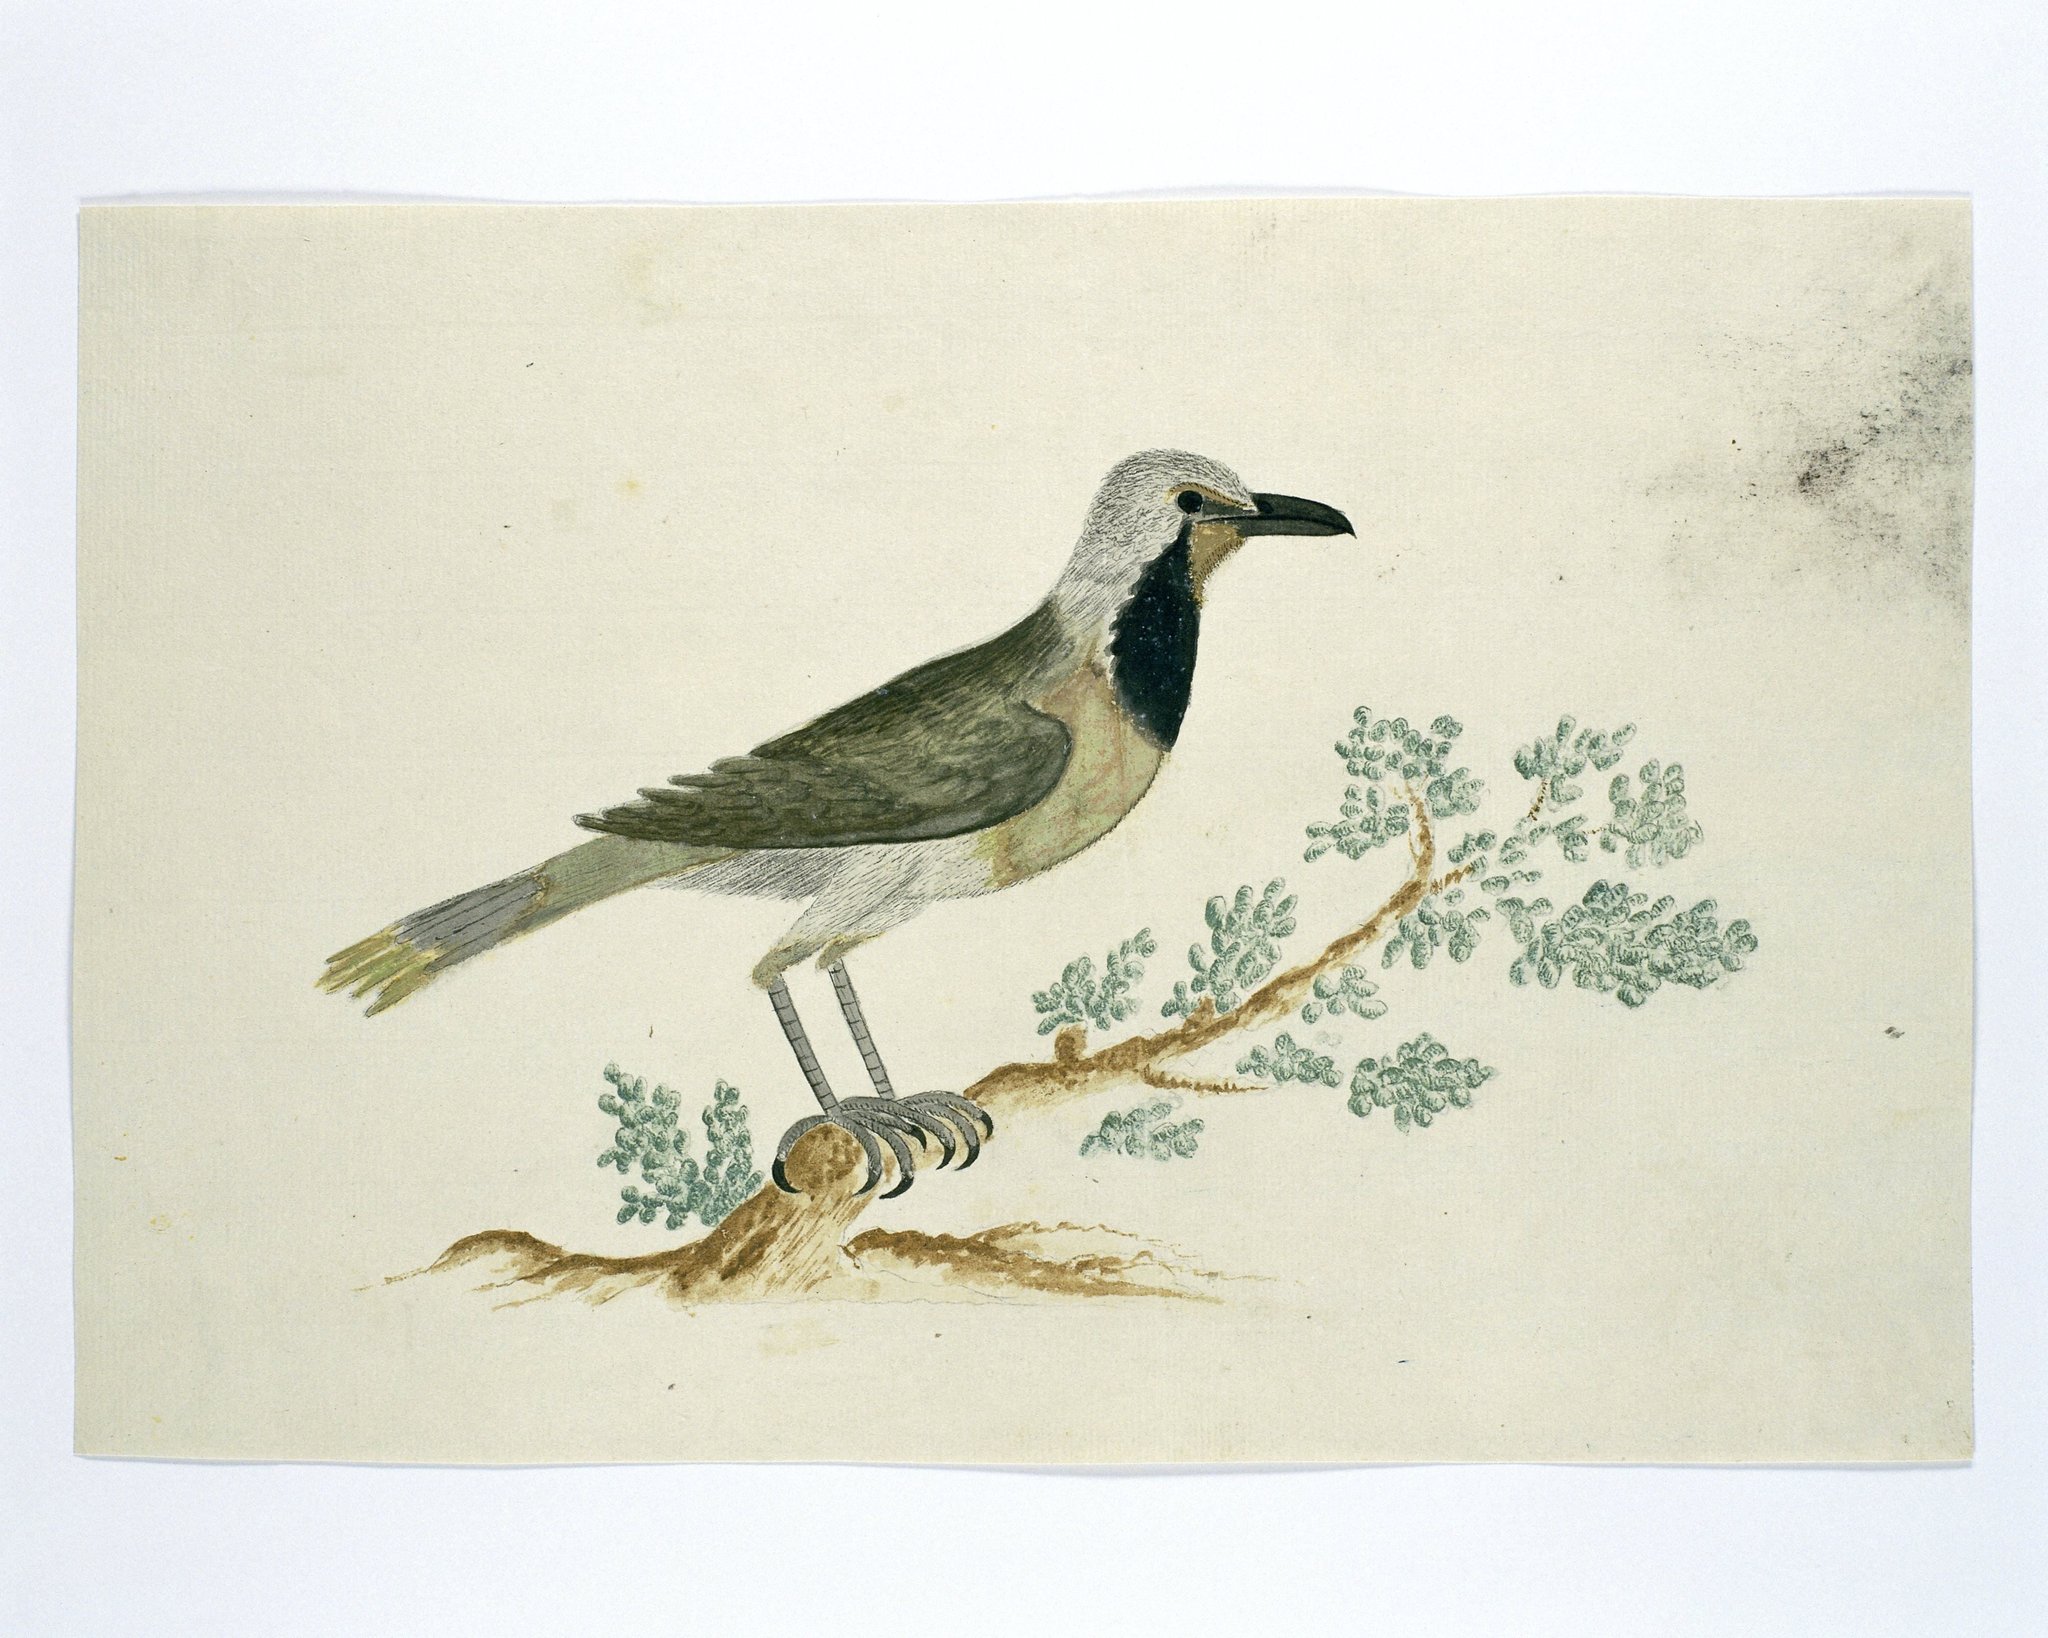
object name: album leaf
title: Telephorus zeylonus (Bokmakierie)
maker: robert jacob gordon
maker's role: draughtsman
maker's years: 1743-1795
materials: chalk, ink, paper, pencil, watercolor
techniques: brush, pen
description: Vogelstudie: Bokmakierie klauwier of wurgvogel (Telophorus zeylonus).